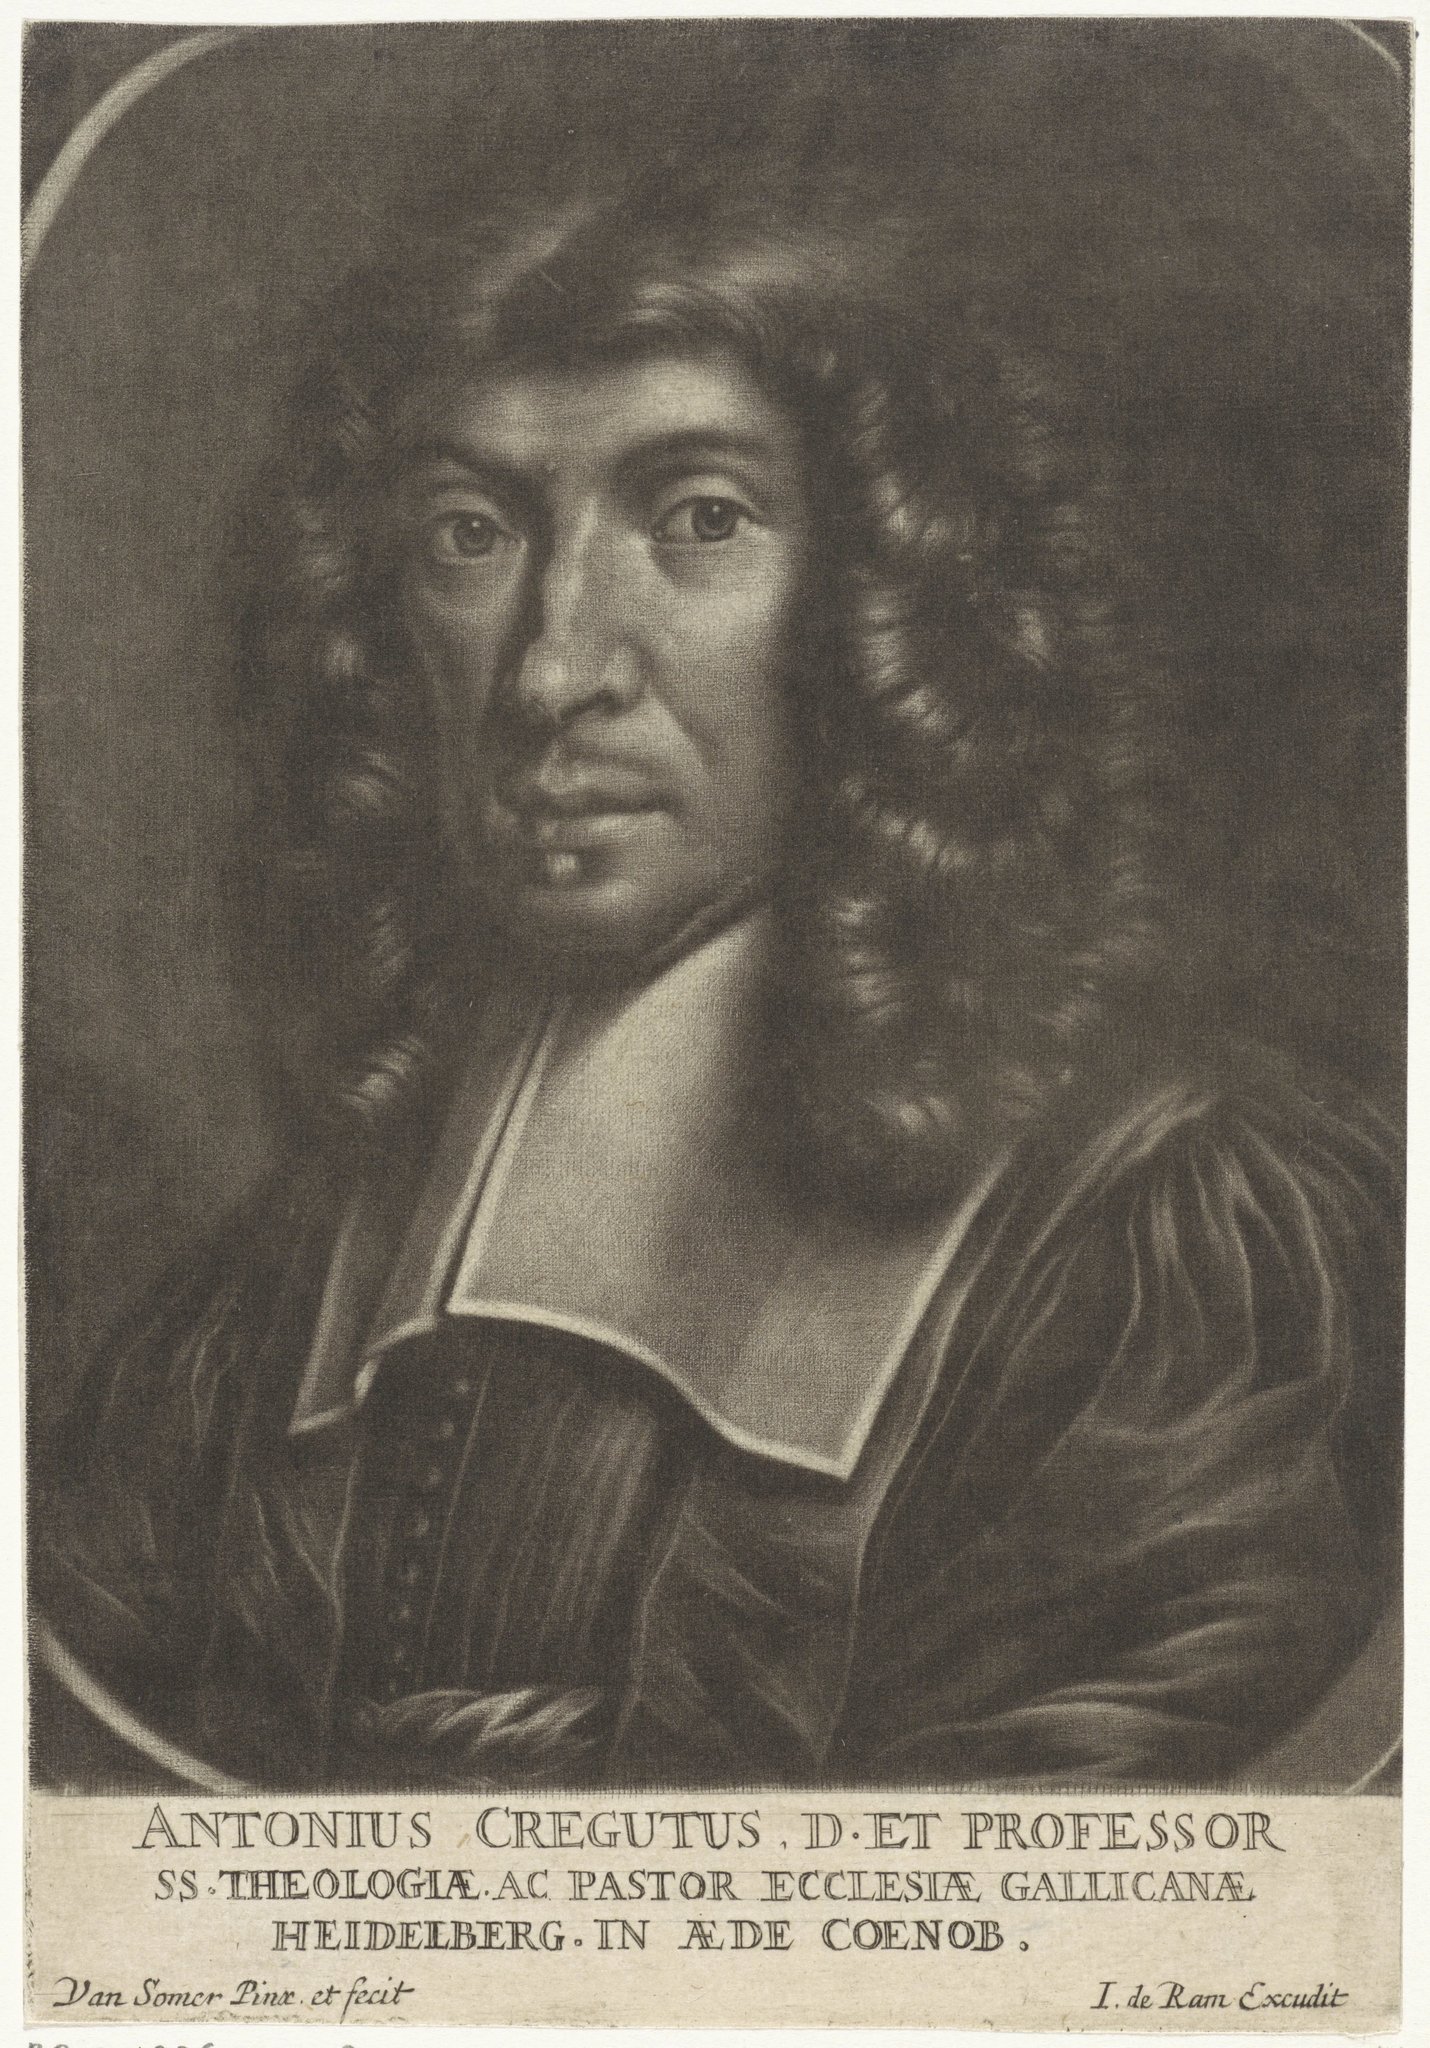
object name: print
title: Portret van de theoloog Antonius Cregutus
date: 1655-1693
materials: paper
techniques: mezzotint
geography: amsterdam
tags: theologian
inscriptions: collector's mark: Lugt 2228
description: Deze prent is de pendant van Hollstein nr. 166 door dezelfde prentmaker.